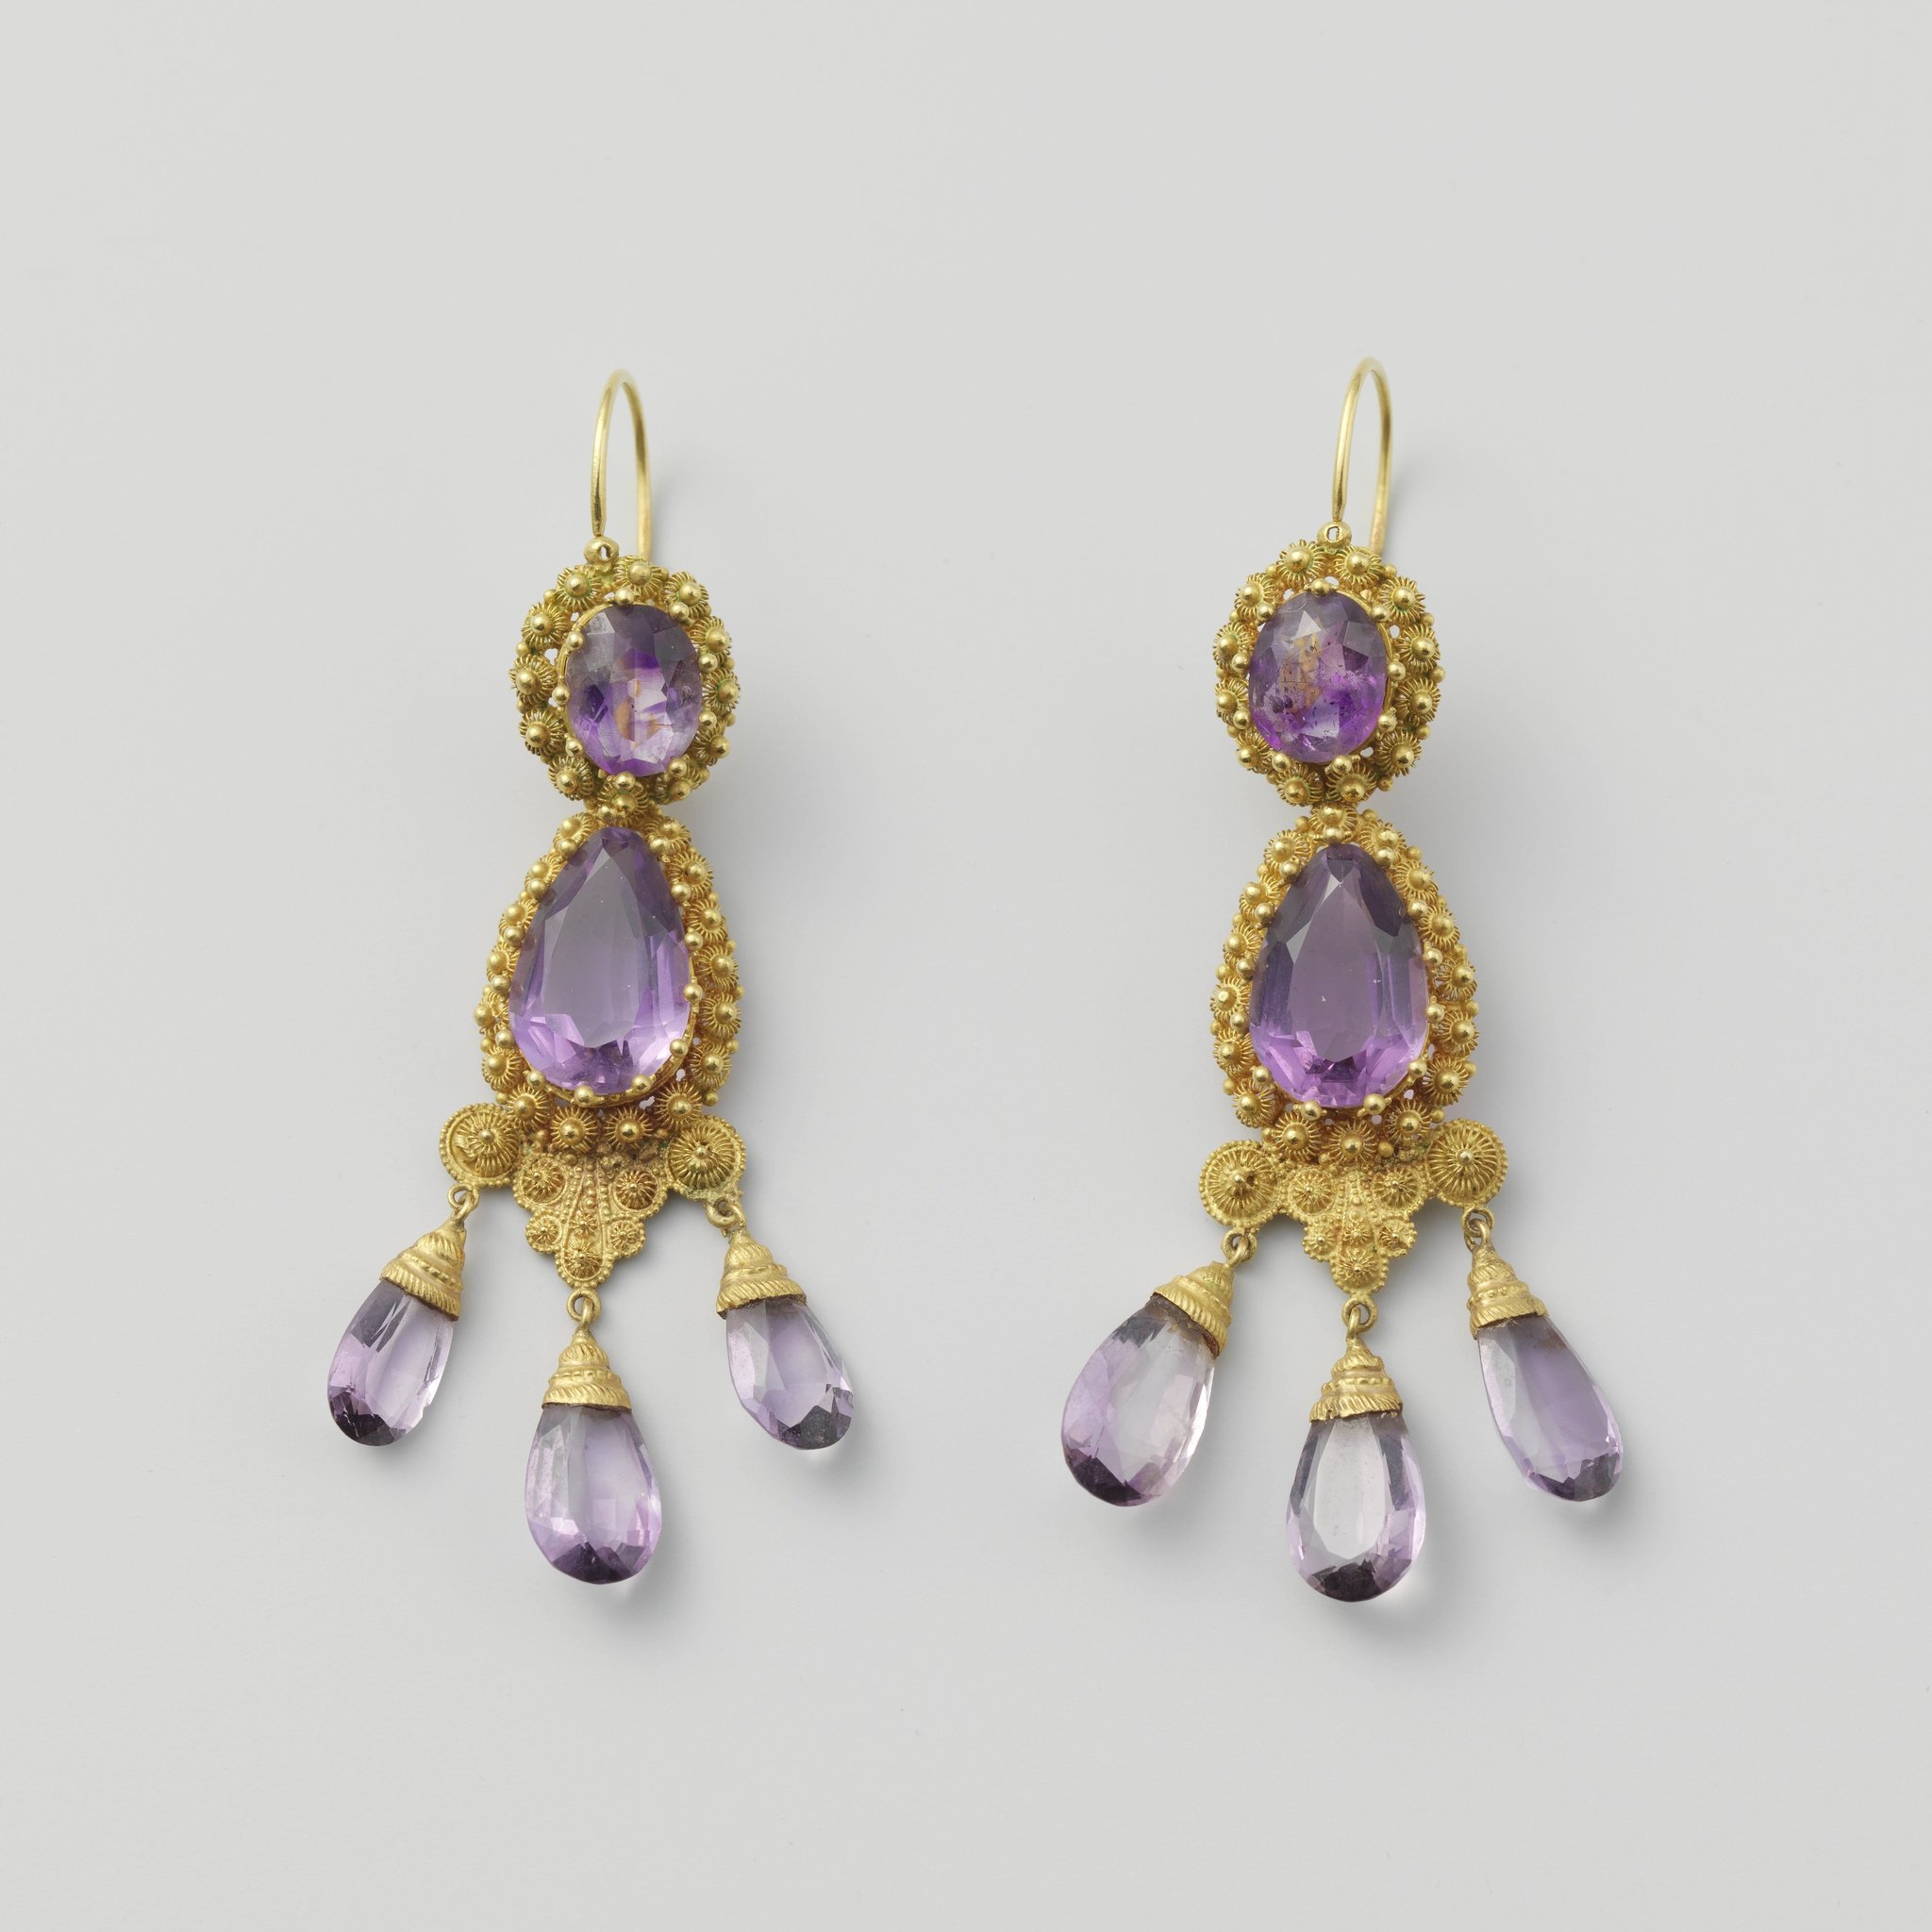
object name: jewellery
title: Stel oorhangers van goud en amethist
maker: jean baptiste bonnard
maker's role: goldsmith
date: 1824-1829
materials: gemstone, gold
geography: amsterdam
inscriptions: alloy mark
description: Parure. Gold and amethyst. Amsterdam, c. 1824 - 1829, by Jean Baptiste Bonnard.